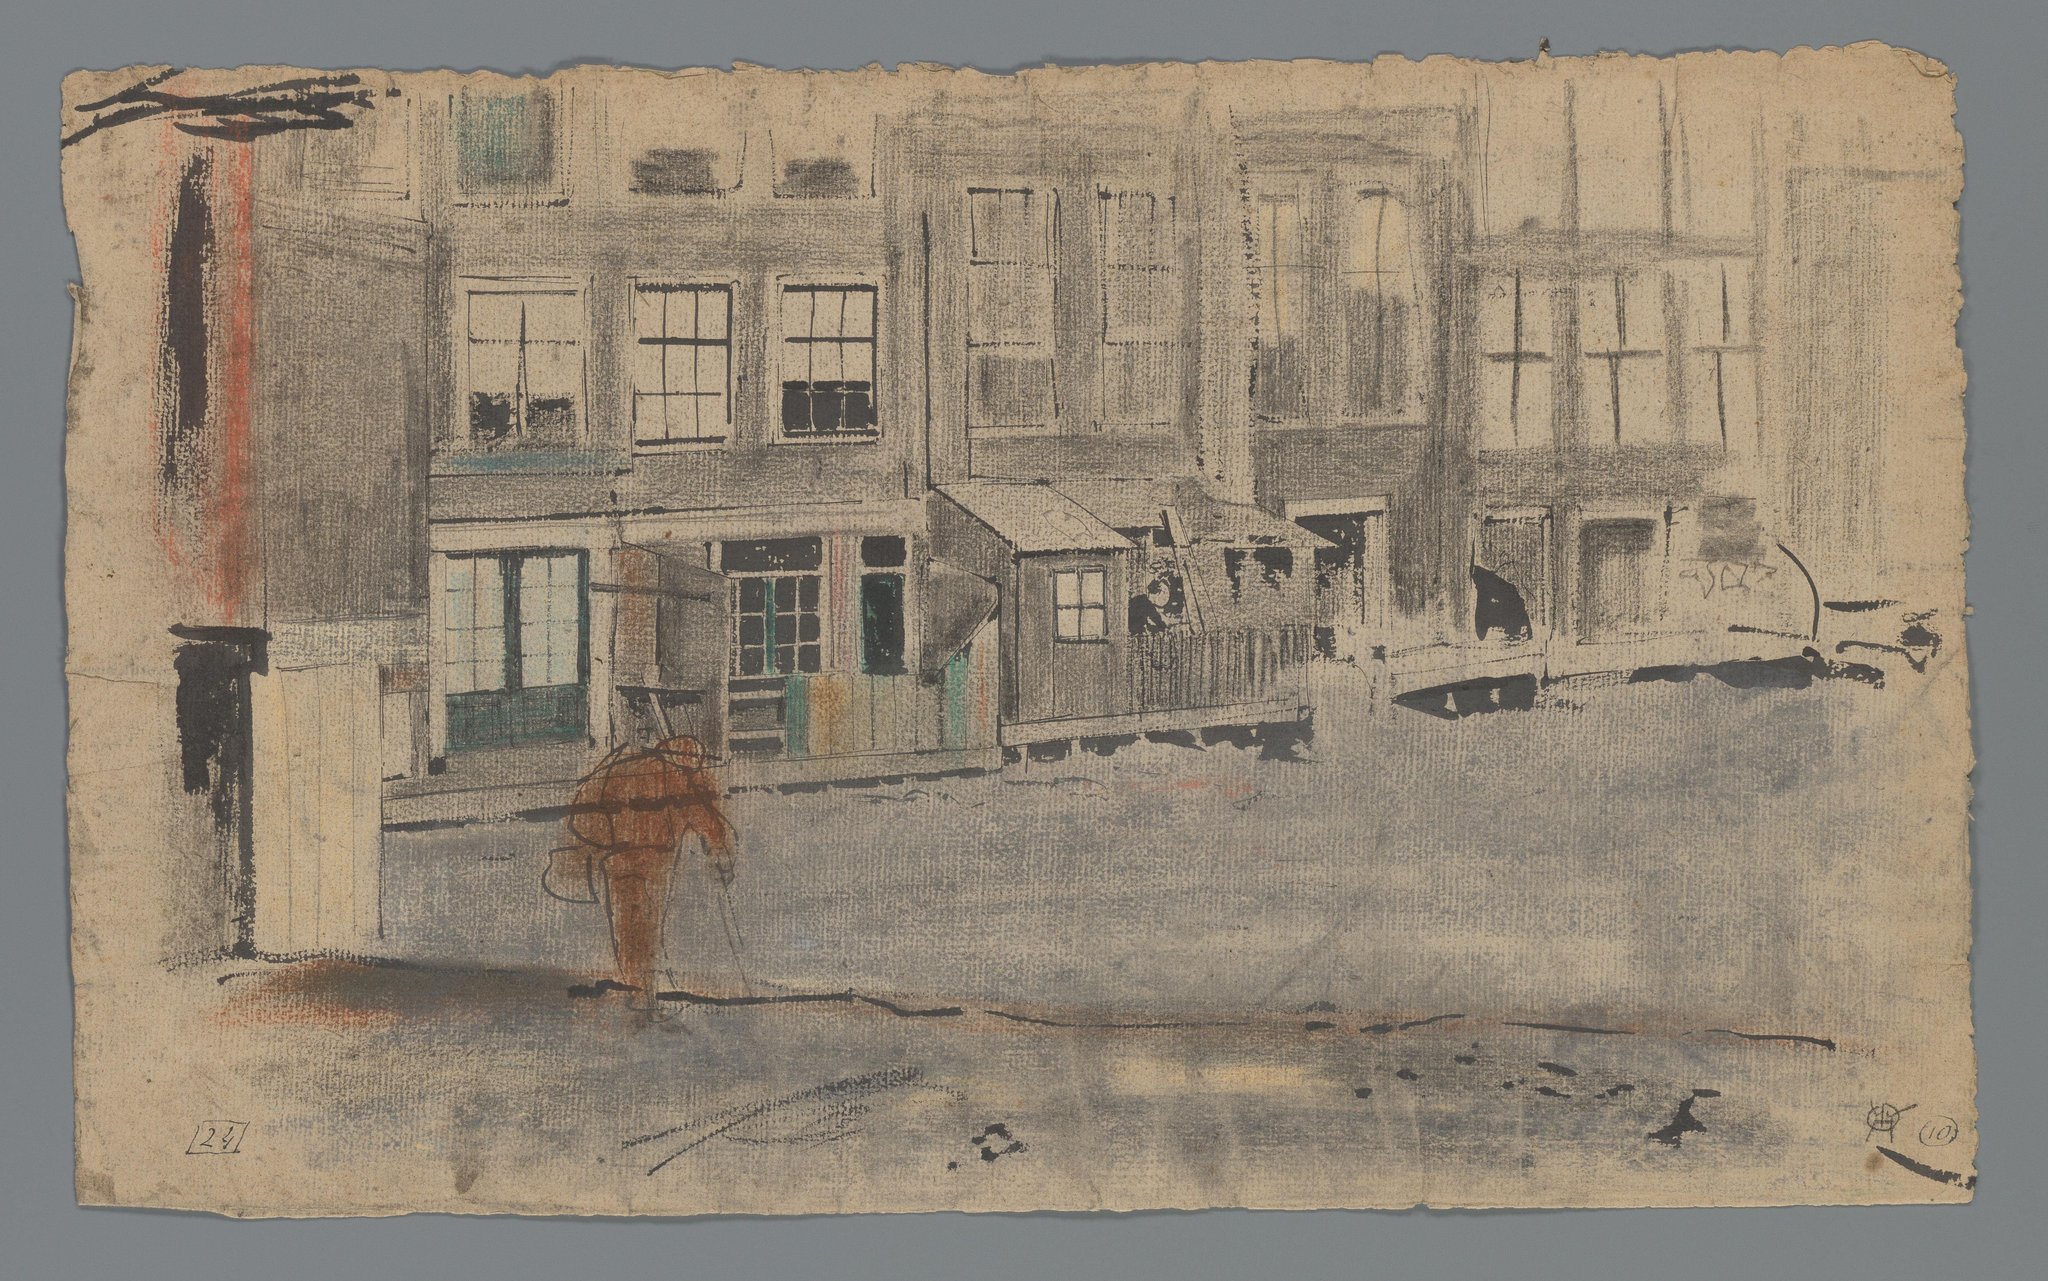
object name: drawing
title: Huizen aan een gracht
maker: gerrit willem dijsselhof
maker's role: designer, draughtsman, print maker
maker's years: 1866-1924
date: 1876-1924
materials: chalk, ink, paper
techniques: brush, pen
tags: street